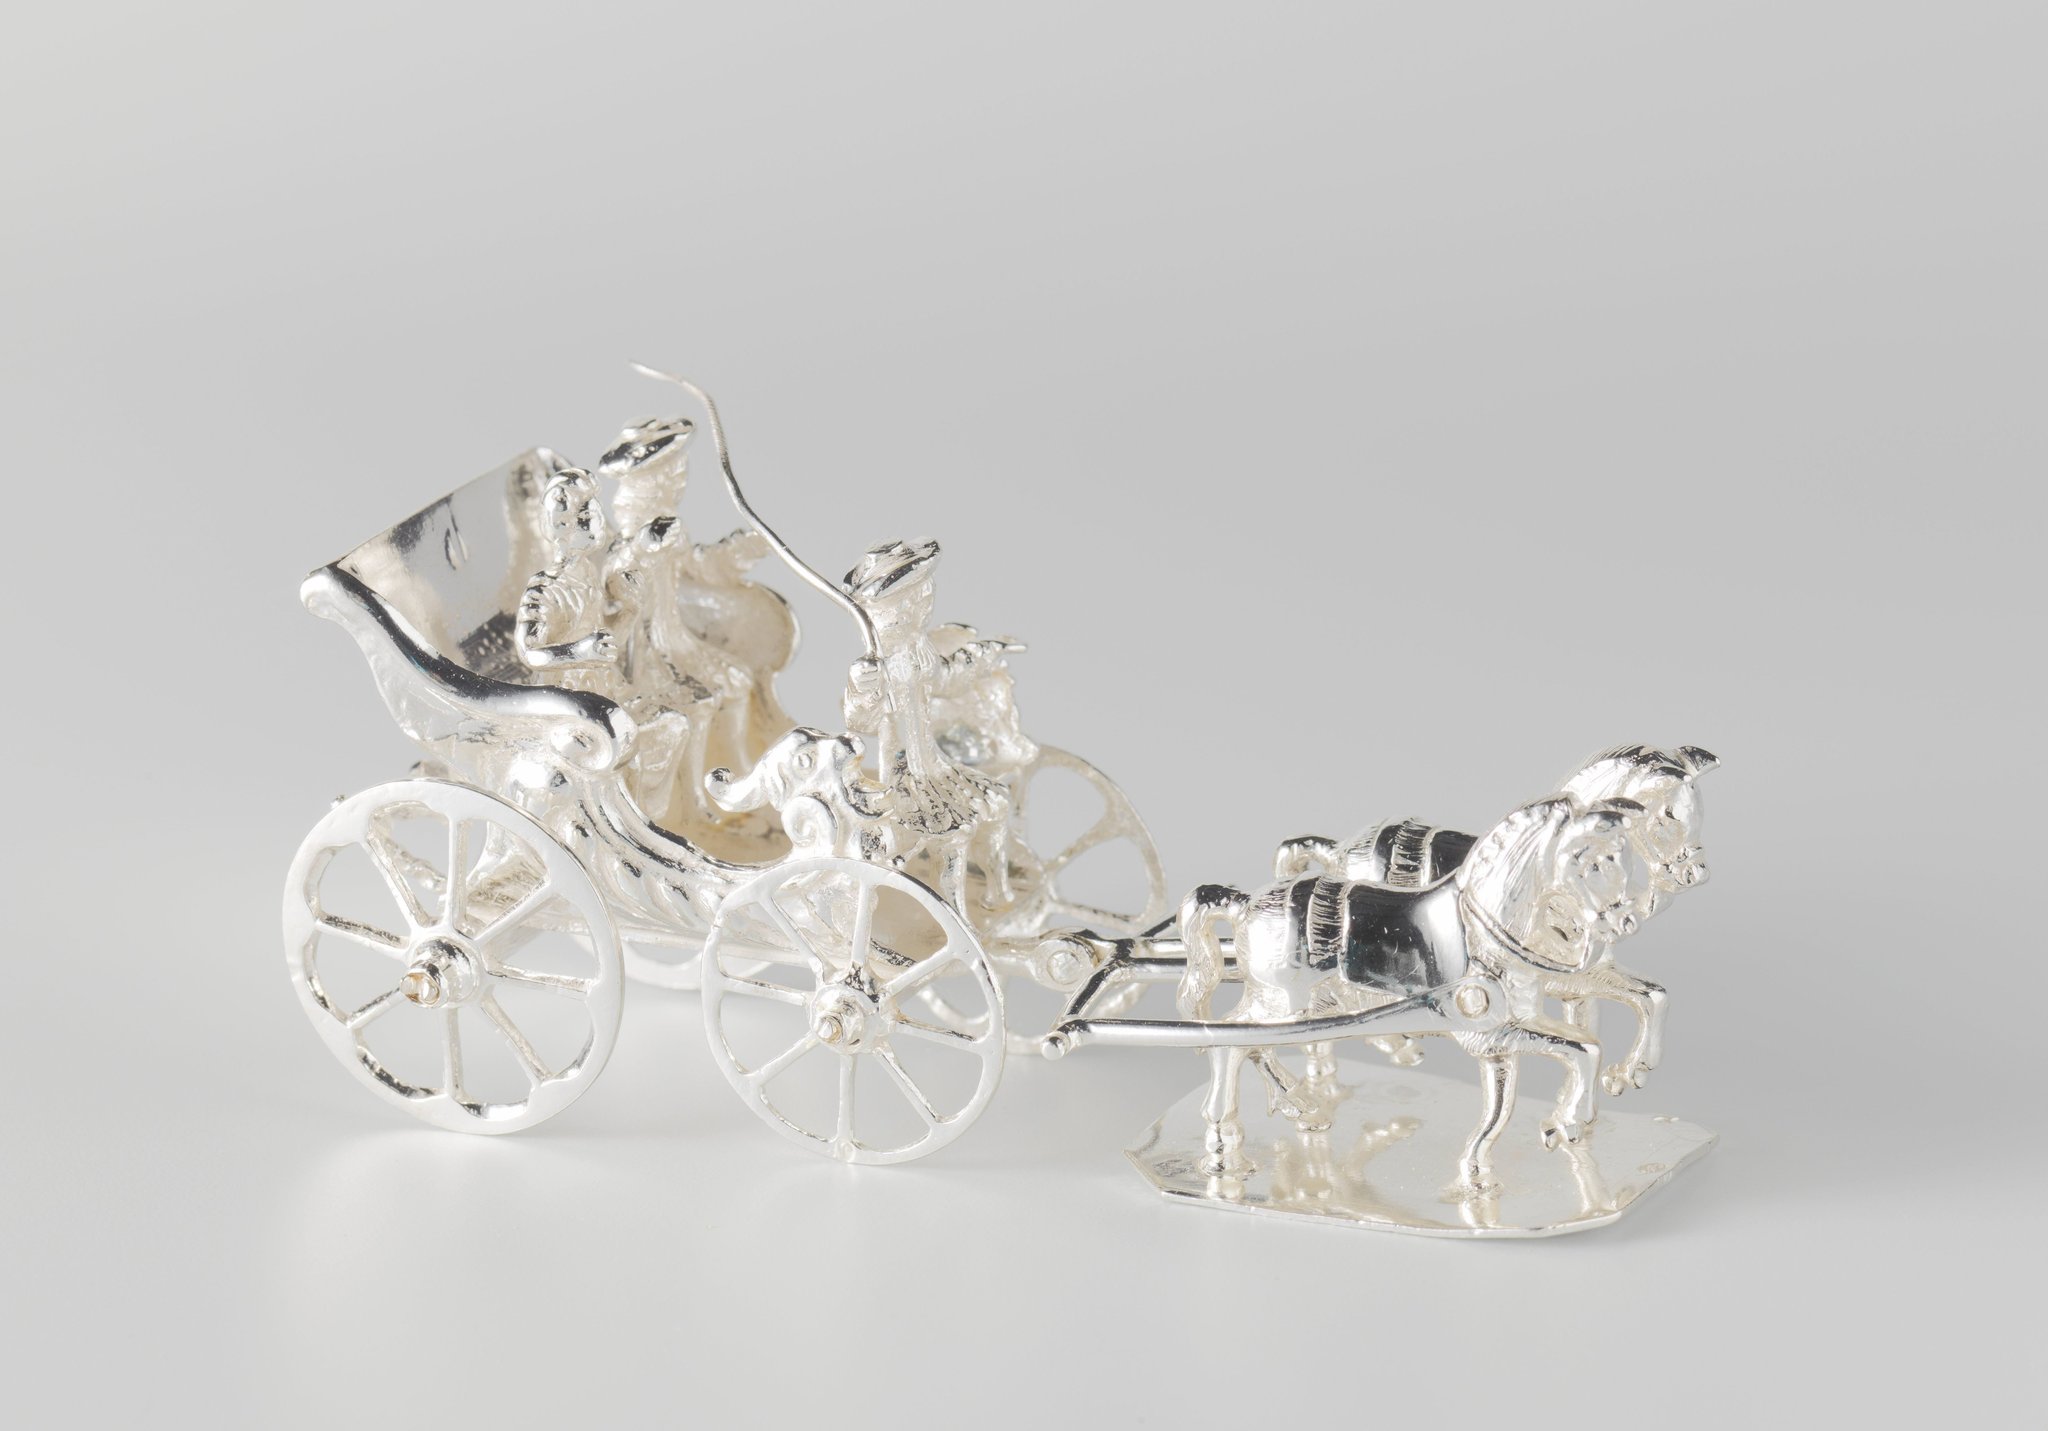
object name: miniature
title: Koets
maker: willem van strant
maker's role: silversmith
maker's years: 1682-1742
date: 1727-1742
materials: silver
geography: amsterdam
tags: four-wheeled vehicle drawn by two animals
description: Wagen met vier wielen, getrokken door twee paarden. De paarden staan op een langwerpige plaat. In de wagen zitten een man en een vrouw. Op de bok van de wagen zit een man met in zijn rechterhand een zweep. Het beeld is gemerkt: stk.= Amsterdam, mt.= Willem van Strant, een bijltje en een Rotterdams herkeur.